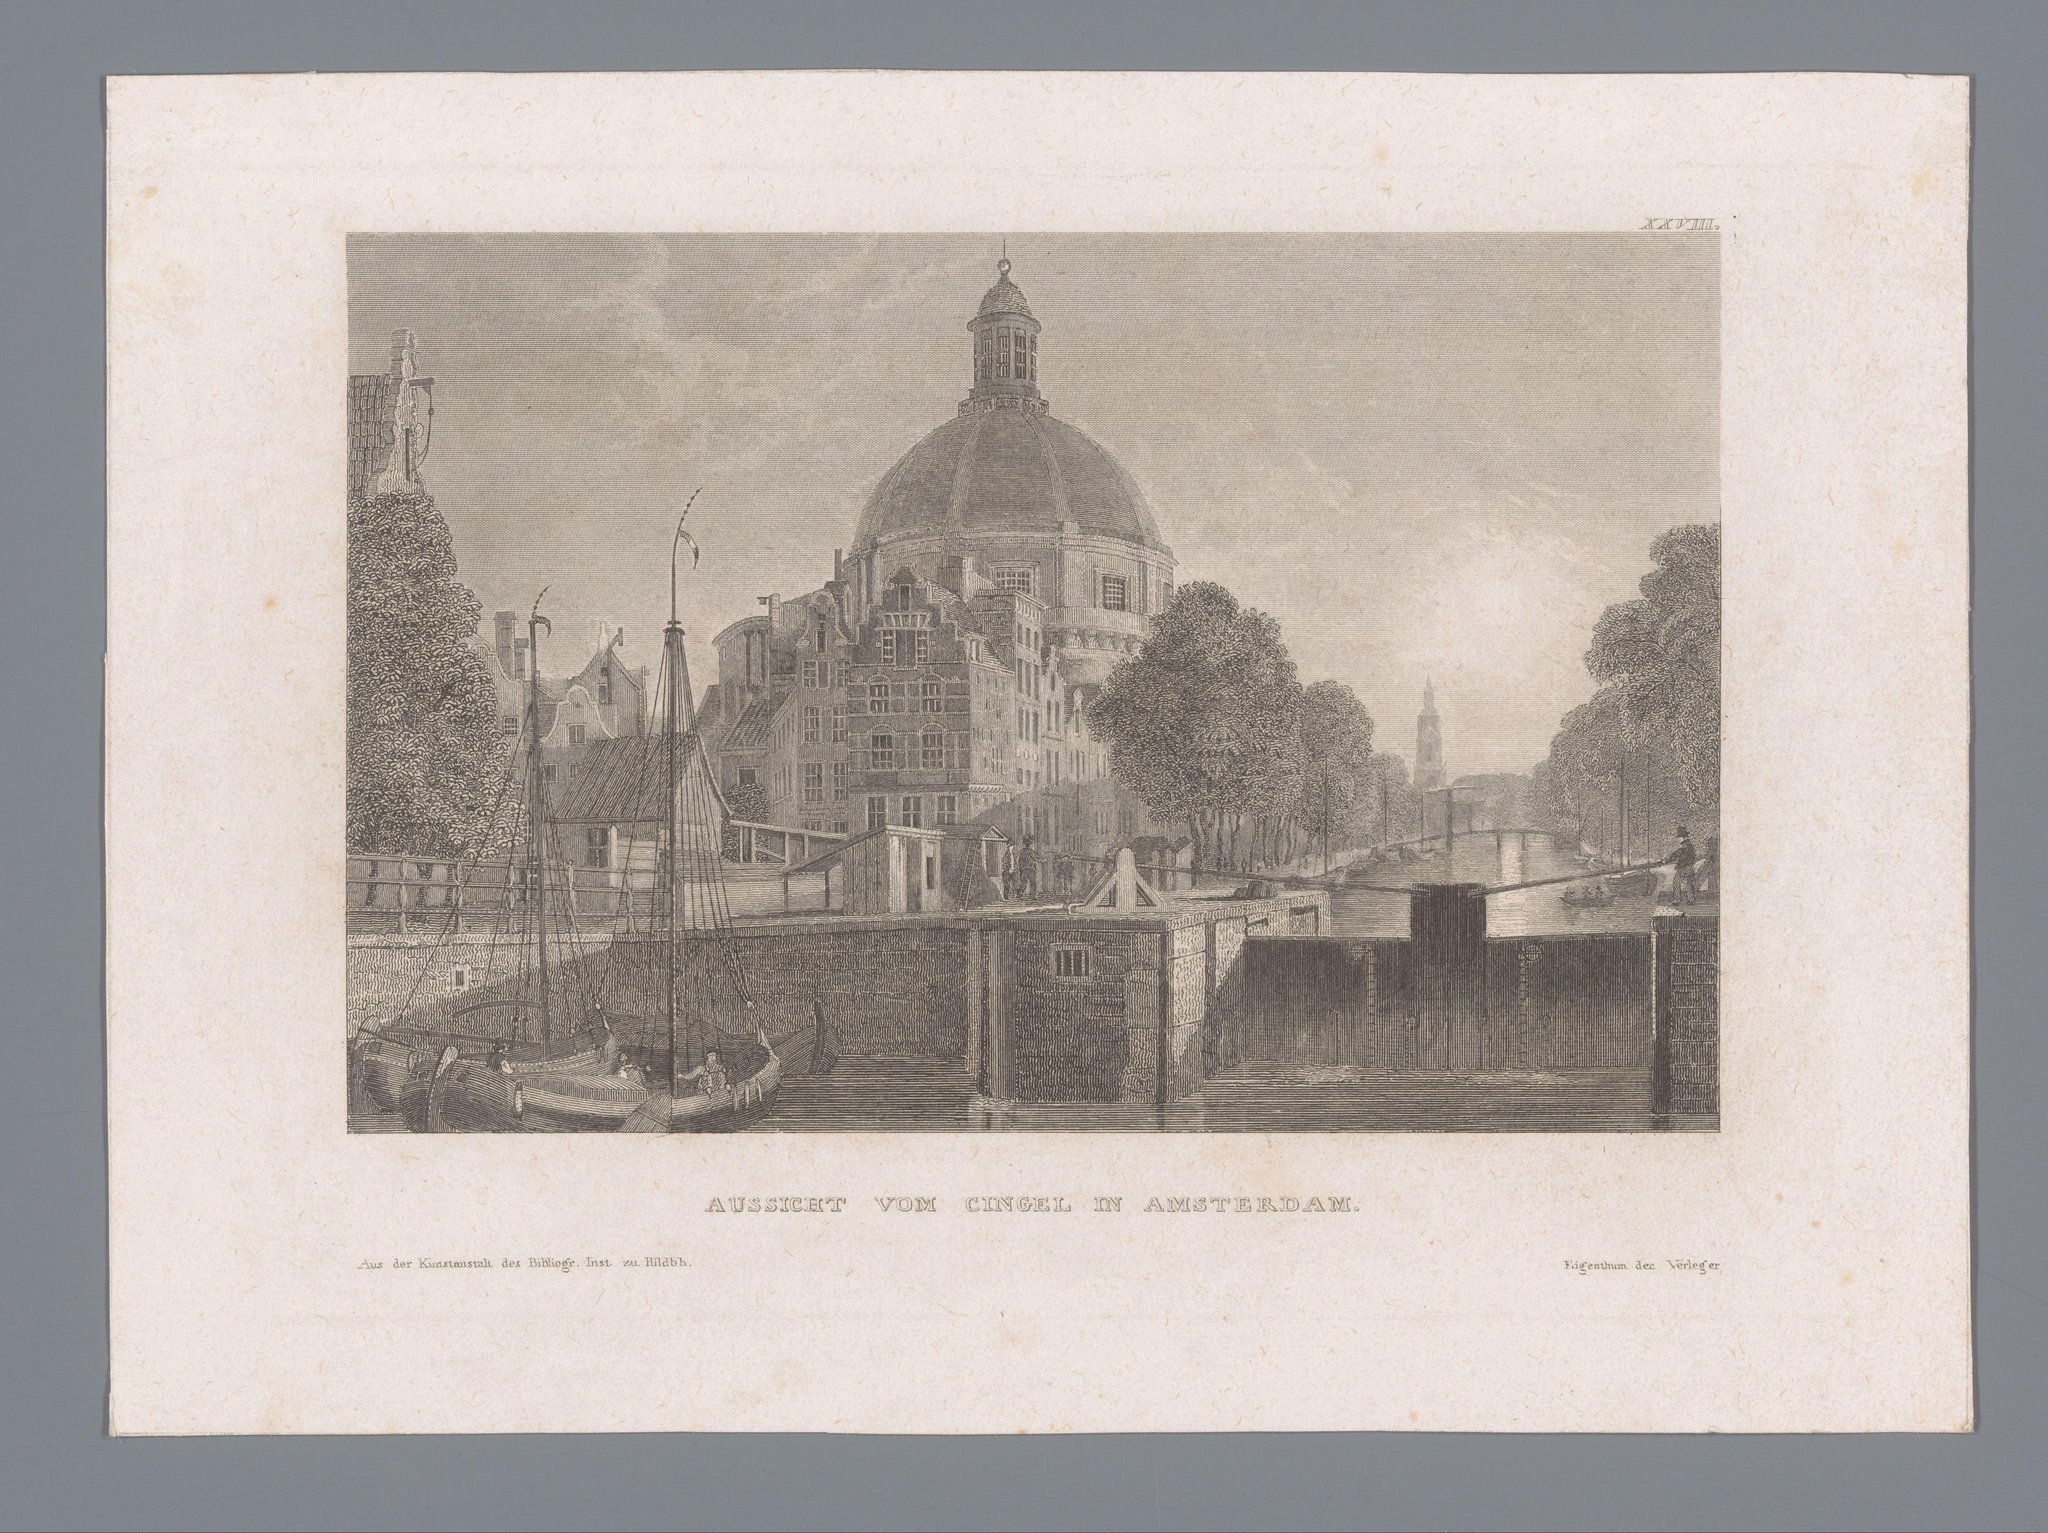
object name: print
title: Gezicht op de Singel in Amsterdam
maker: robert batty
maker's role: artist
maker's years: 1789-1848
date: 1831-1850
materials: paper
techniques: engraving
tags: canals, waters (in city), lift-lock, canal lock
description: Prent verschenen in: Meyer, Joseph. Meyer's Universum. Hildburghausen: Bibliographisches Institut, 1835-1863.